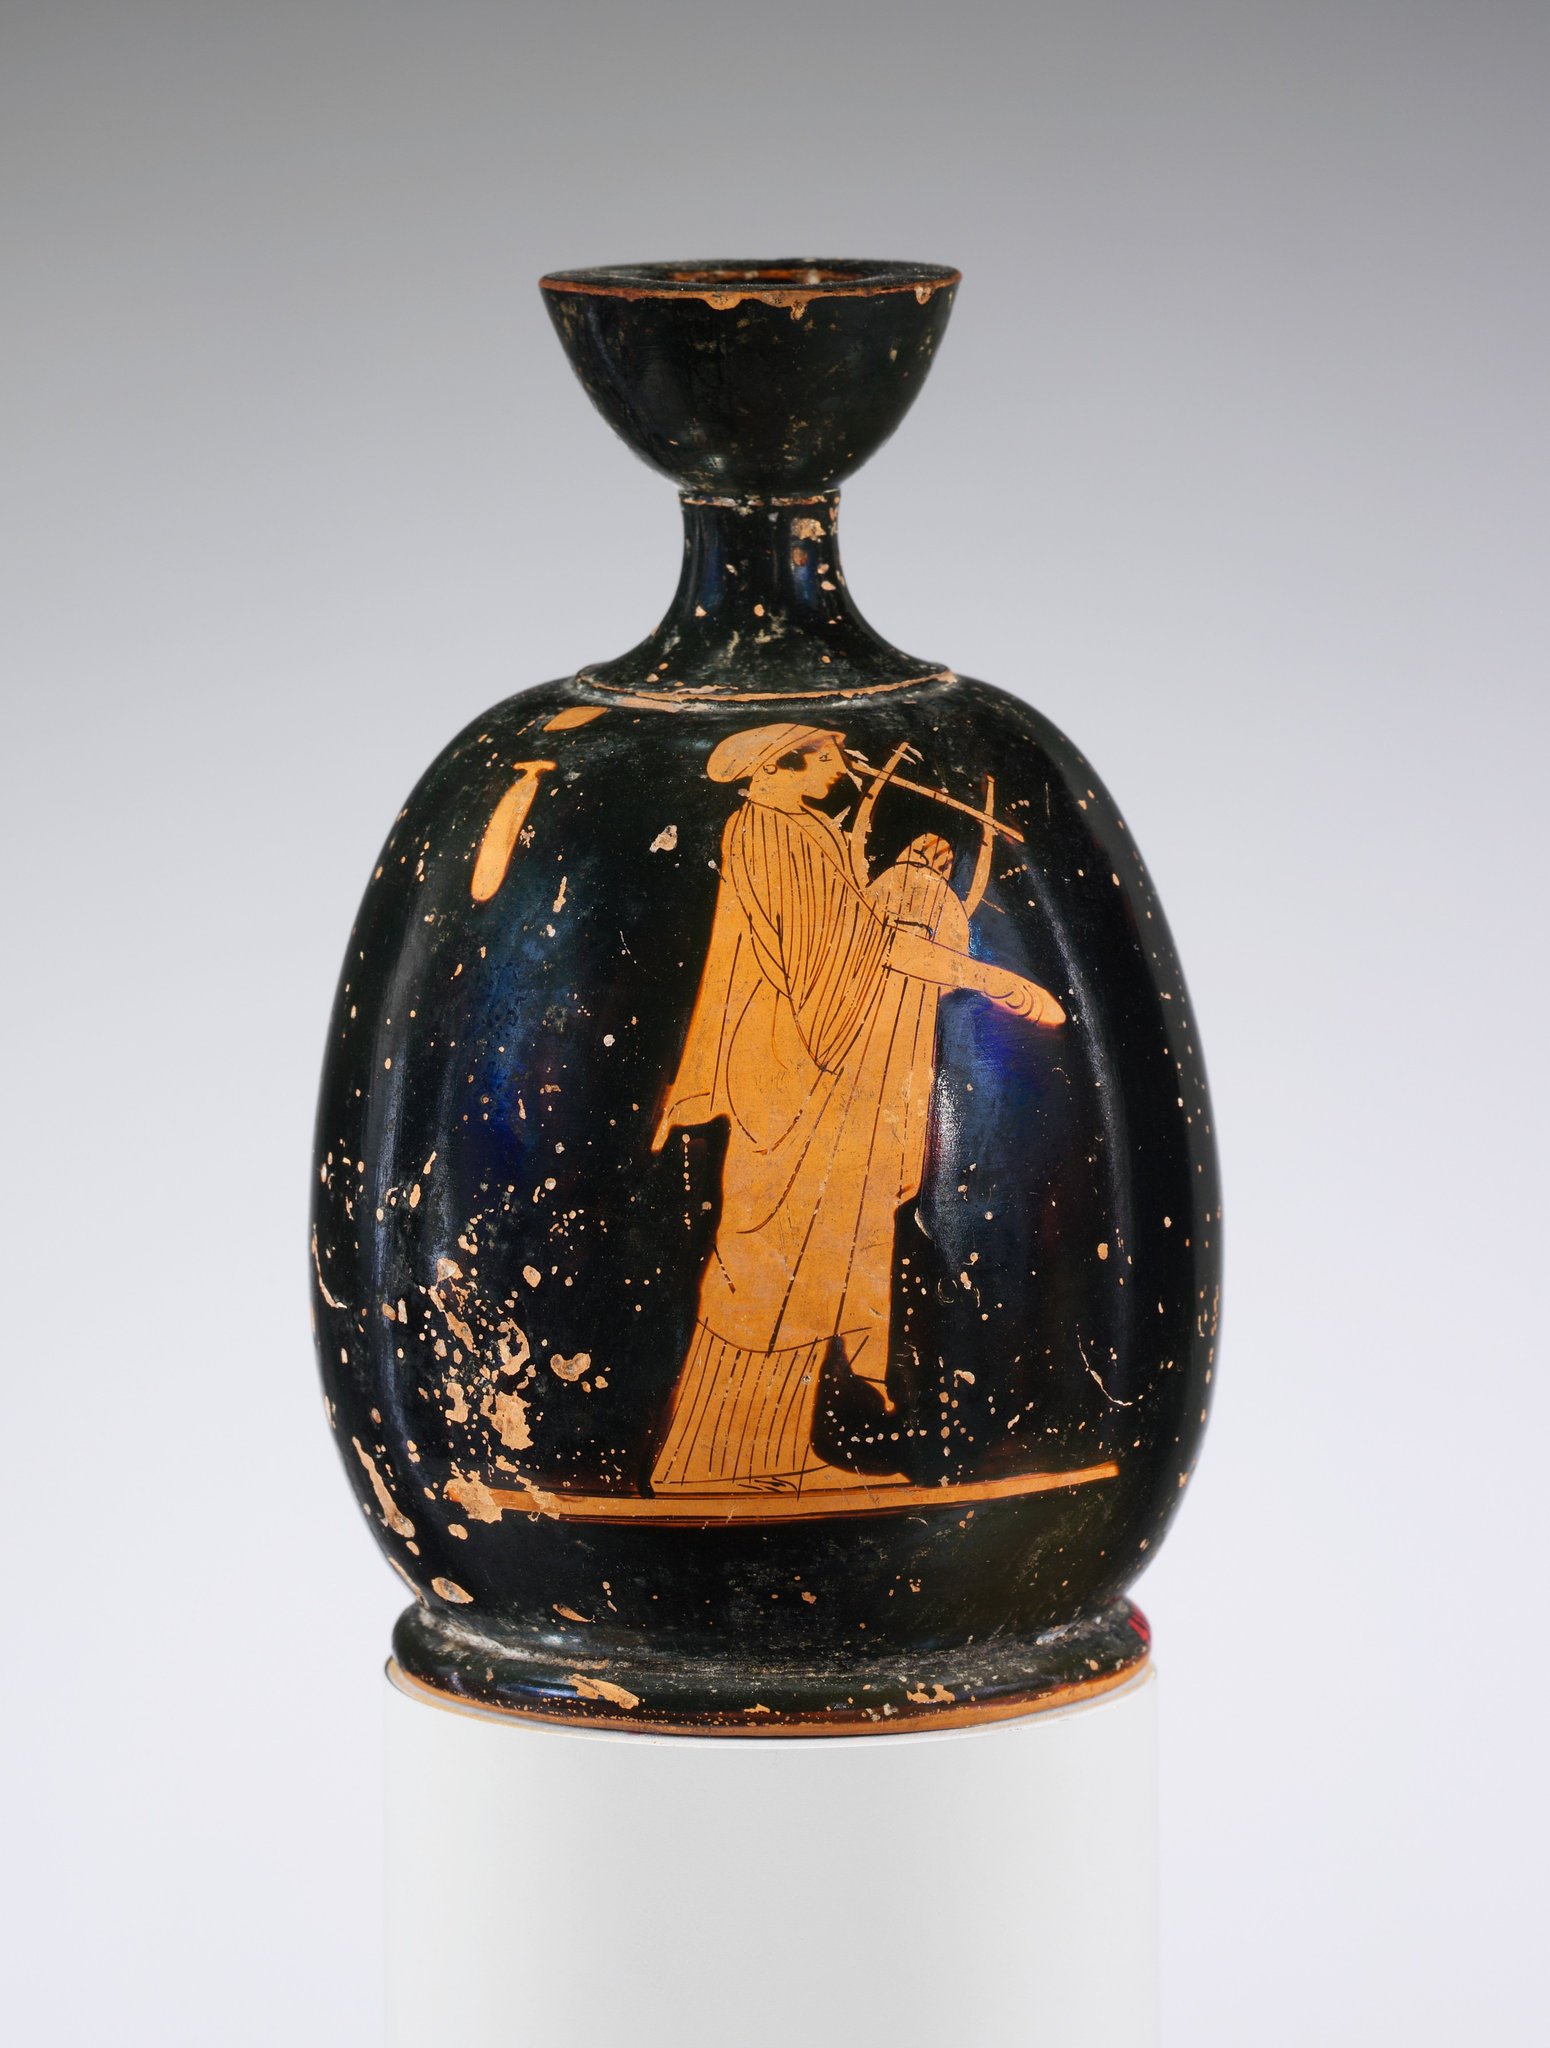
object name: squat lekythos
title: Terracotta squat lekythos (oil flask)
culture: greek, attic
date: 470-460 BCE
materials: terracotta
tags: musical instruments,women